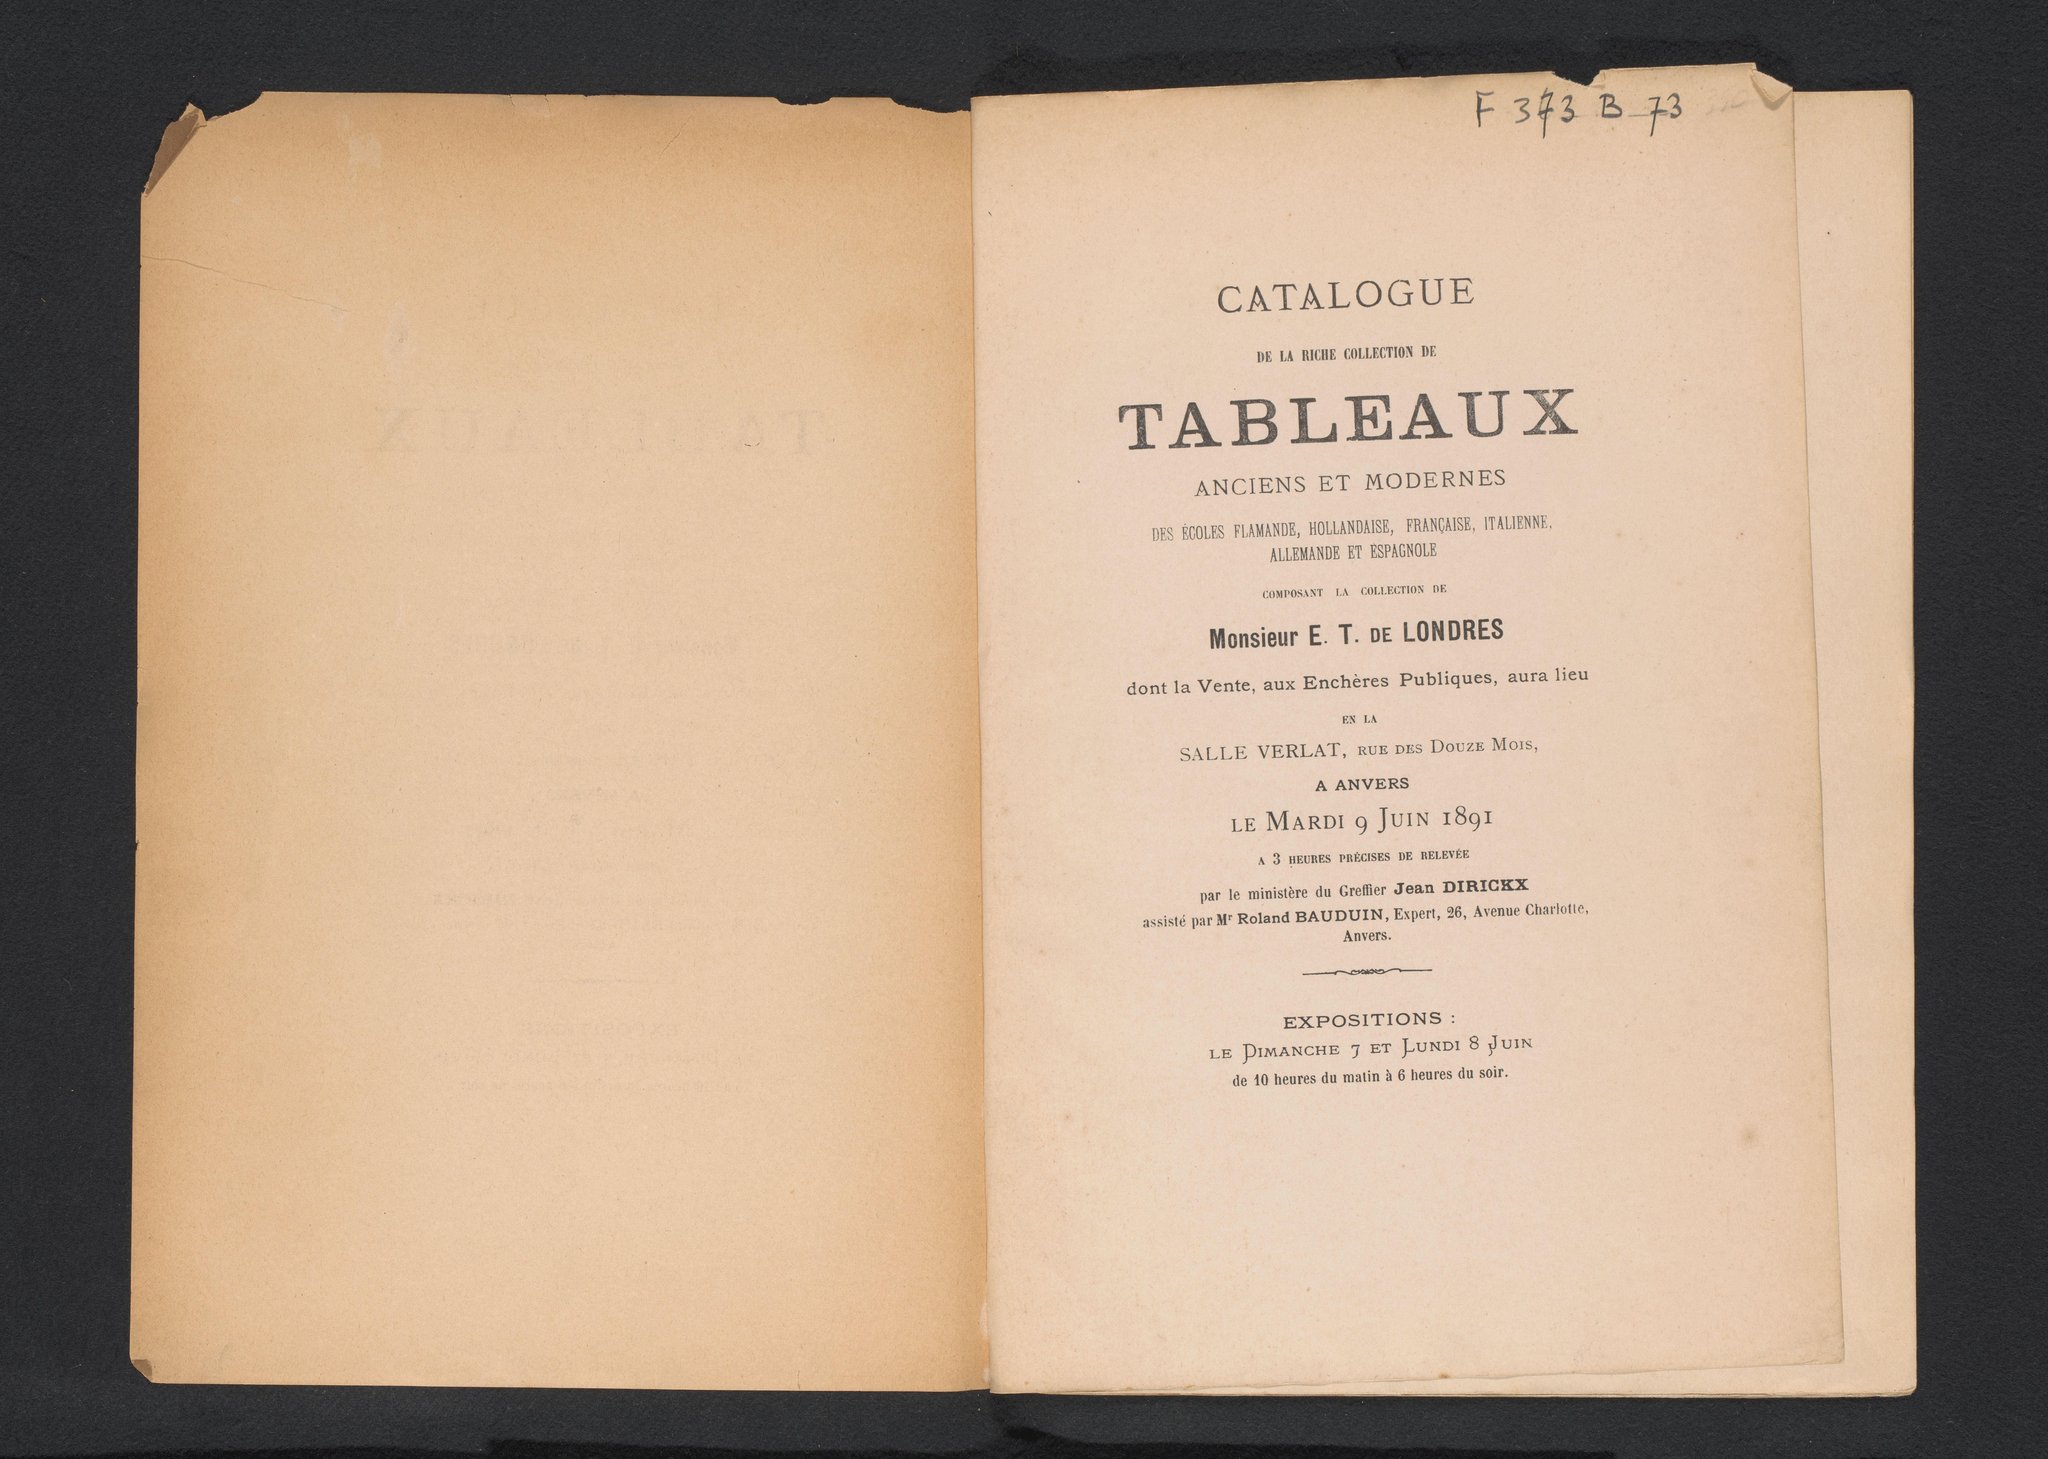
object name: book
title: Catalogue de la riche collection de tableaux anciens et modernes des écoles flamande, hollandaise, française, italienne, allemande et espagnole composant la collection de monsieur E.T. de Londres / [photographe Georges Raynaud]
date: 1891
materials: paper, photographic support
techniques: printing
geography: antwerp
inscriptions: bookplate: ‘BIBLIOTHEEK/ RIJKSMUSEUM/ AMSTERDAM’, number: ‘9’, annotation: ‘Foto.’, bookplate: ‘ROLAND BAUDUIN/ ANVERS’